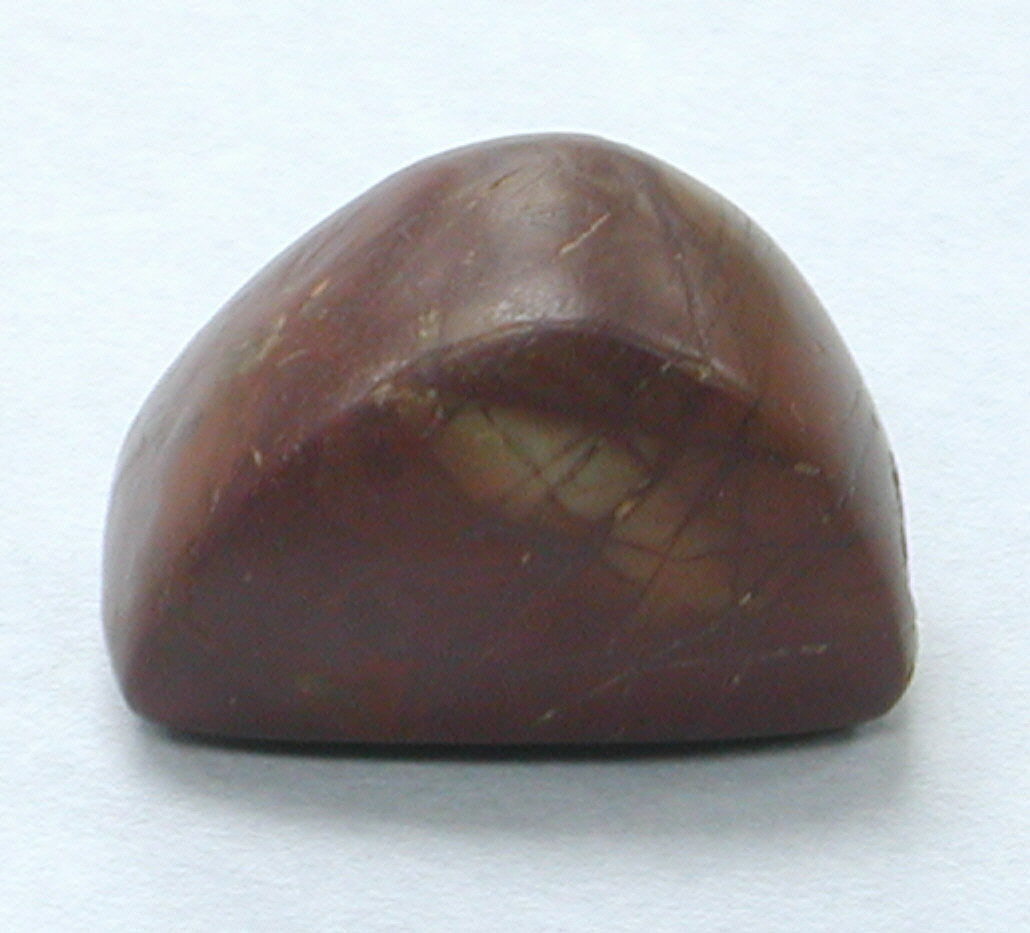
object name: ritual stone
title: Stone Pulidor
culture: mexican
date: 1501-1600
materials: stone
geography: mexico